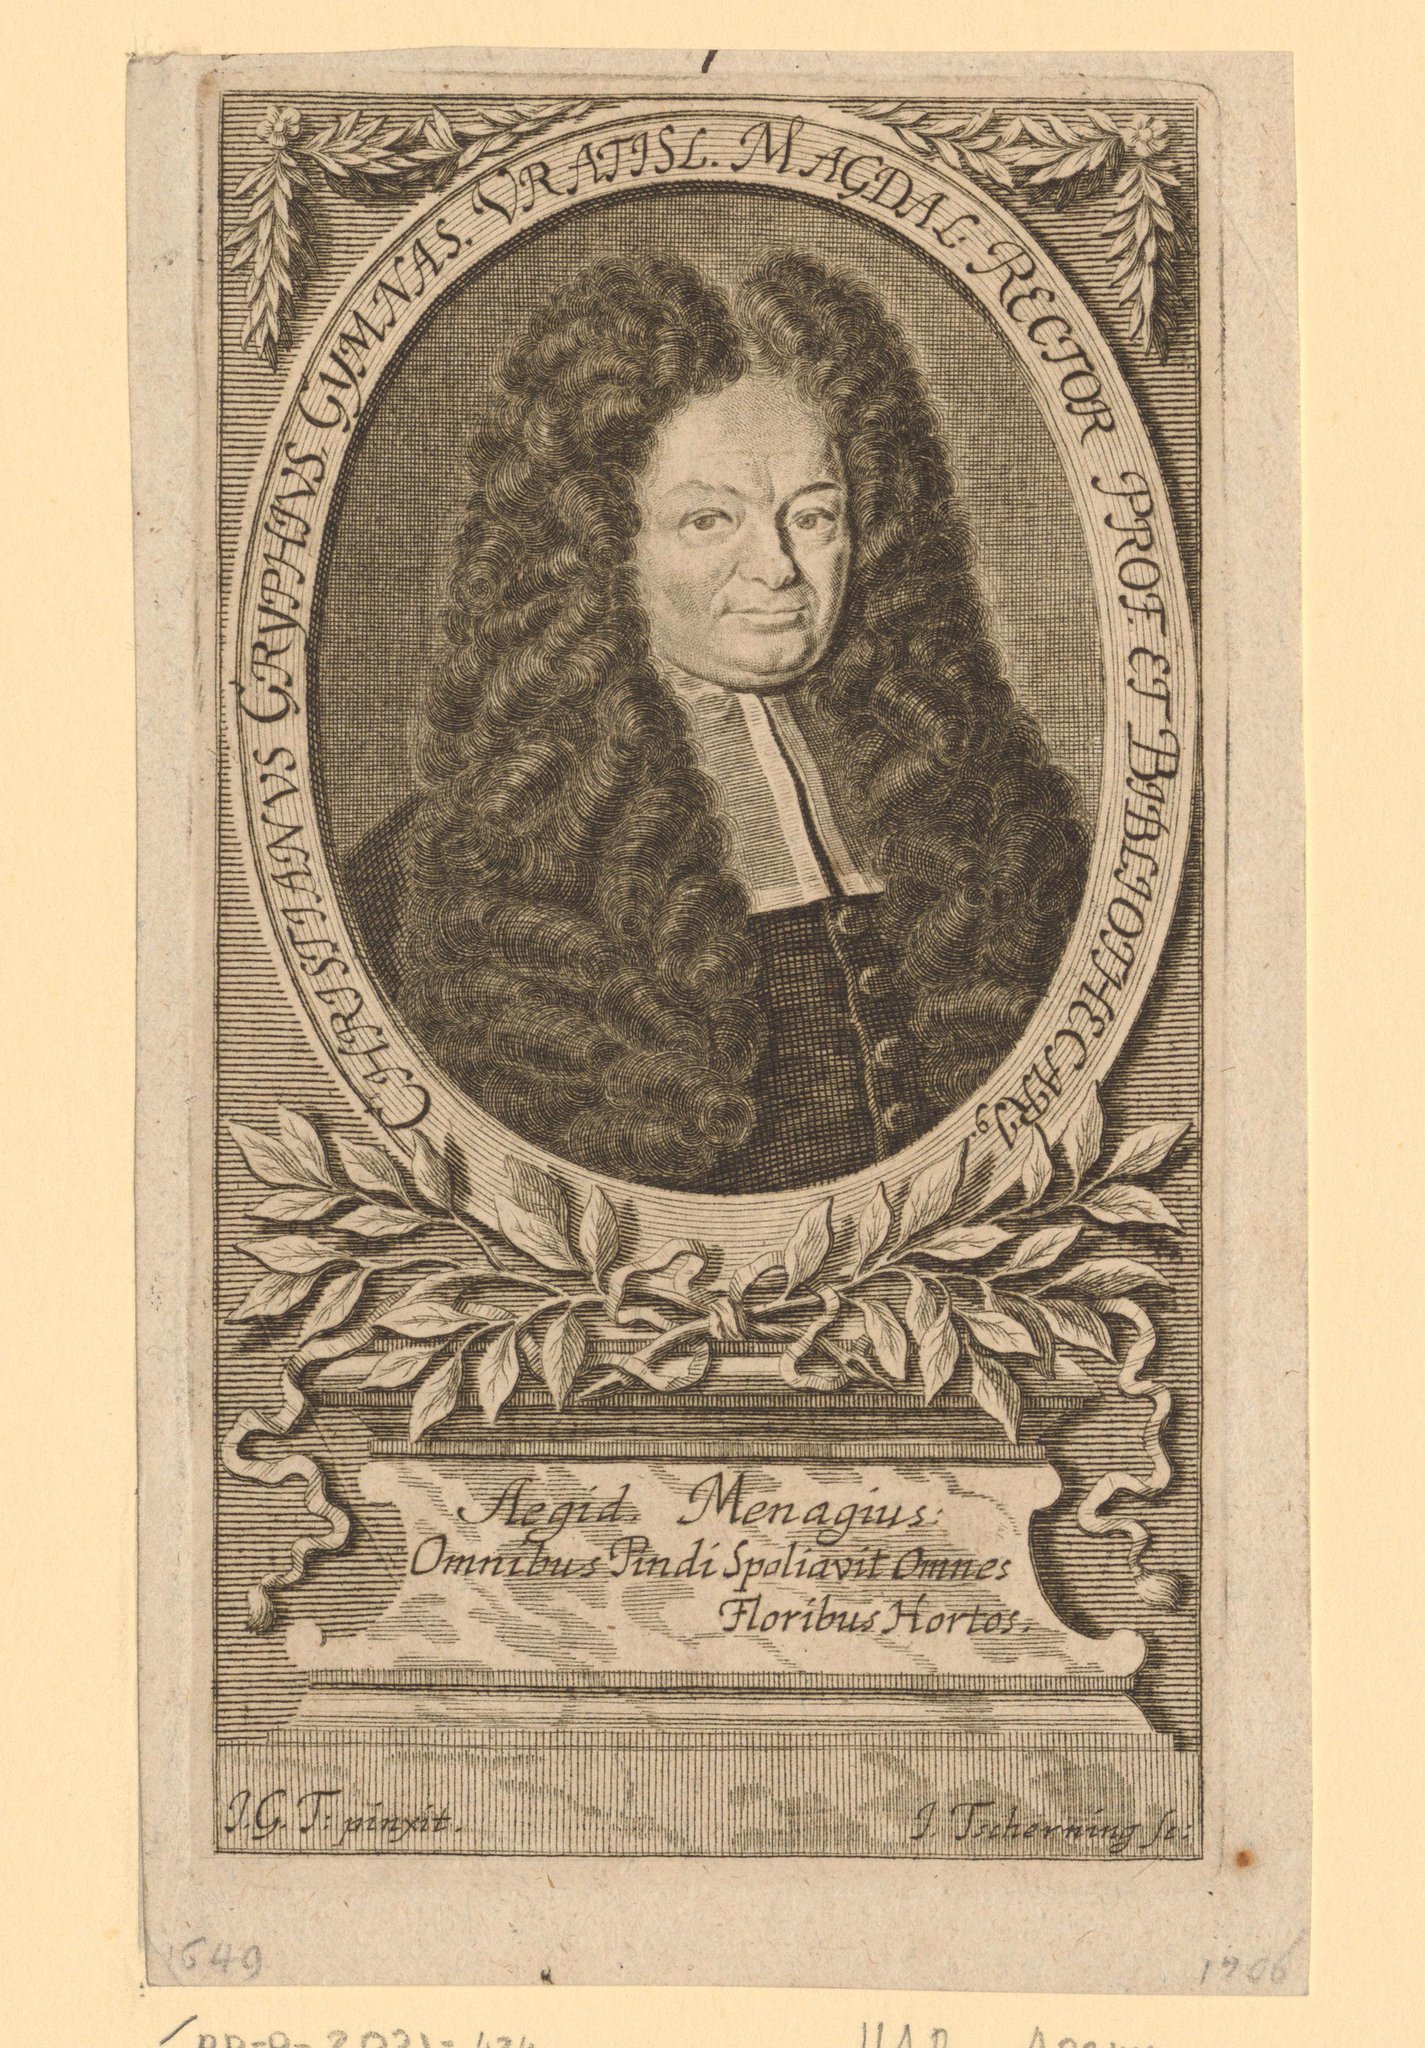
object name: print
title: Portret van Christian Gryphius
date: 1707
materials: paper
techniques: engraving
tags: poland, historical persons, portrait of a writer, writer, poet, author, professor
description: Prent waarschijnlijk uit: Christiani Gryphii Poetische Wälder. Frankfurt am Main en Leipzig: Christian Bauch, 1707.